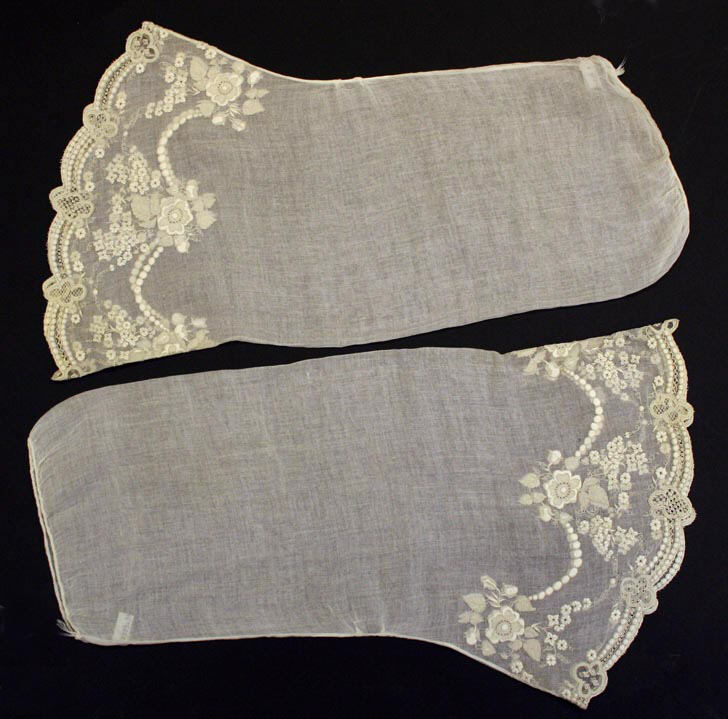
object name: undersleeves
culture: american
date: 1850-1859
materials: cotton